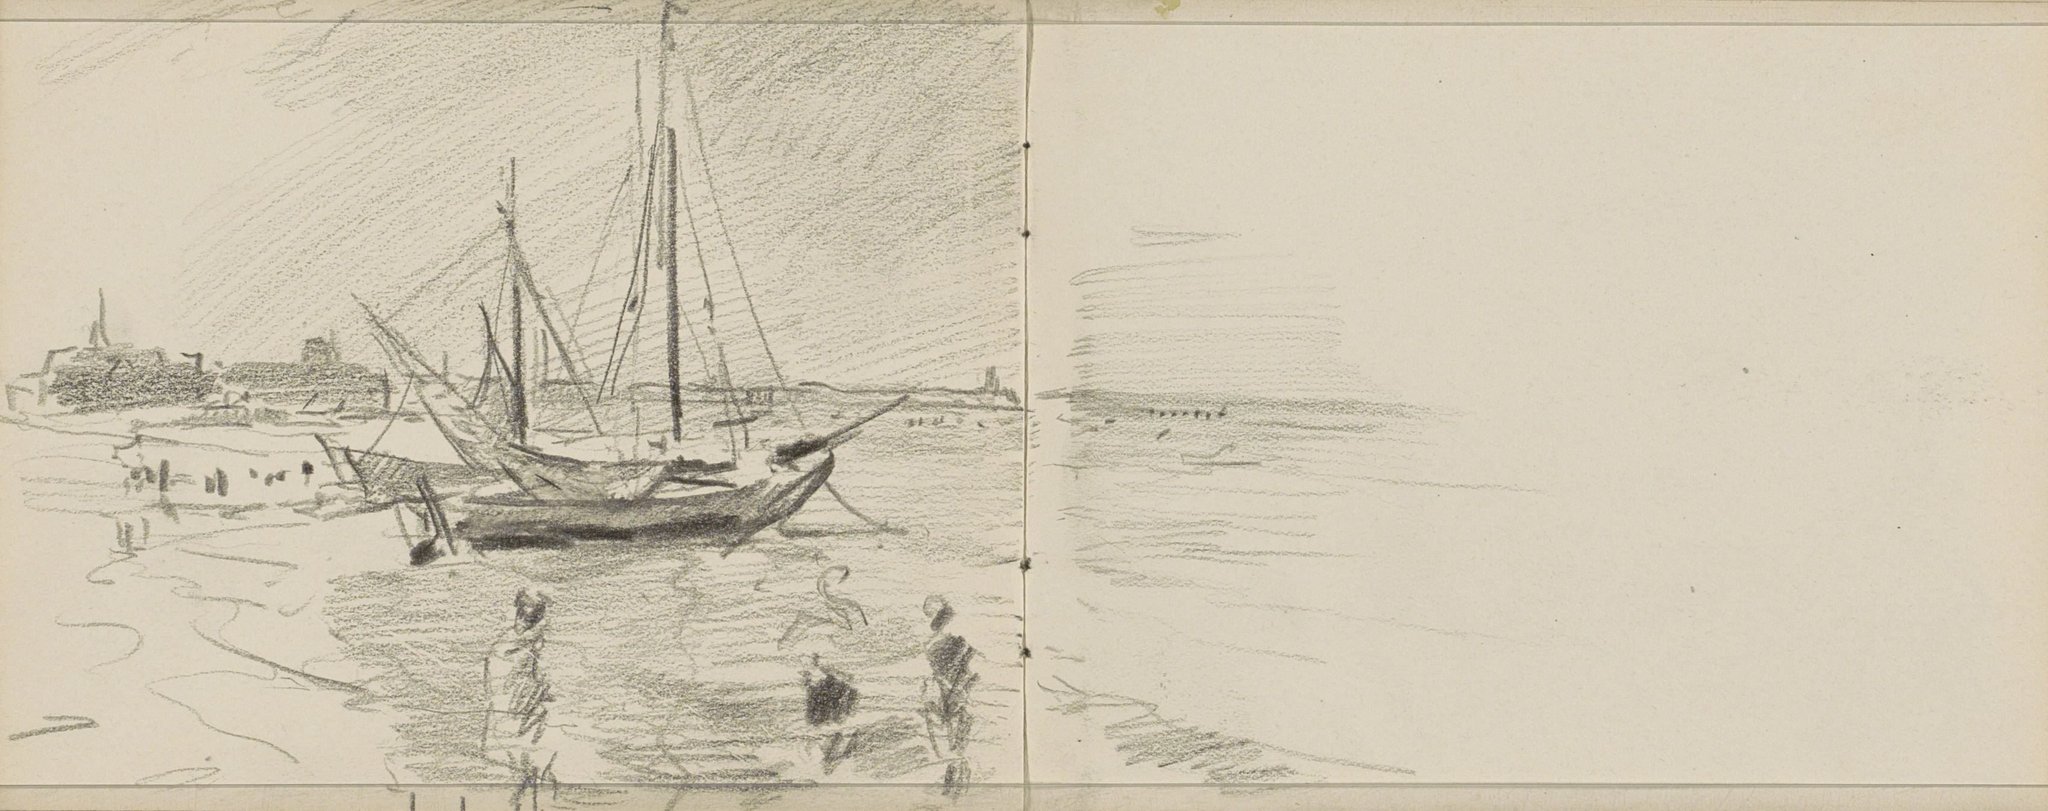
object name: sketchbook leaf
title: Zeilschip voor de kust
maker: johan antonie de jonge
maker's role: draughtsman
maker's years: 1864-1927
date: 1881-1927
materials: chalk, paper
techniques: stumping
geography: south holland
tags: city-view, and landscape with man-made constructions, sailing-ship, sailing-boat, in or beside the water (on the beach)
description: In de branding ligt een zeilschip voor anker. Vooraan figuren. In de verte een stadsgezicht. Blad 28 verso en blad 29 recto uit een schetsboek met 29 bladen.